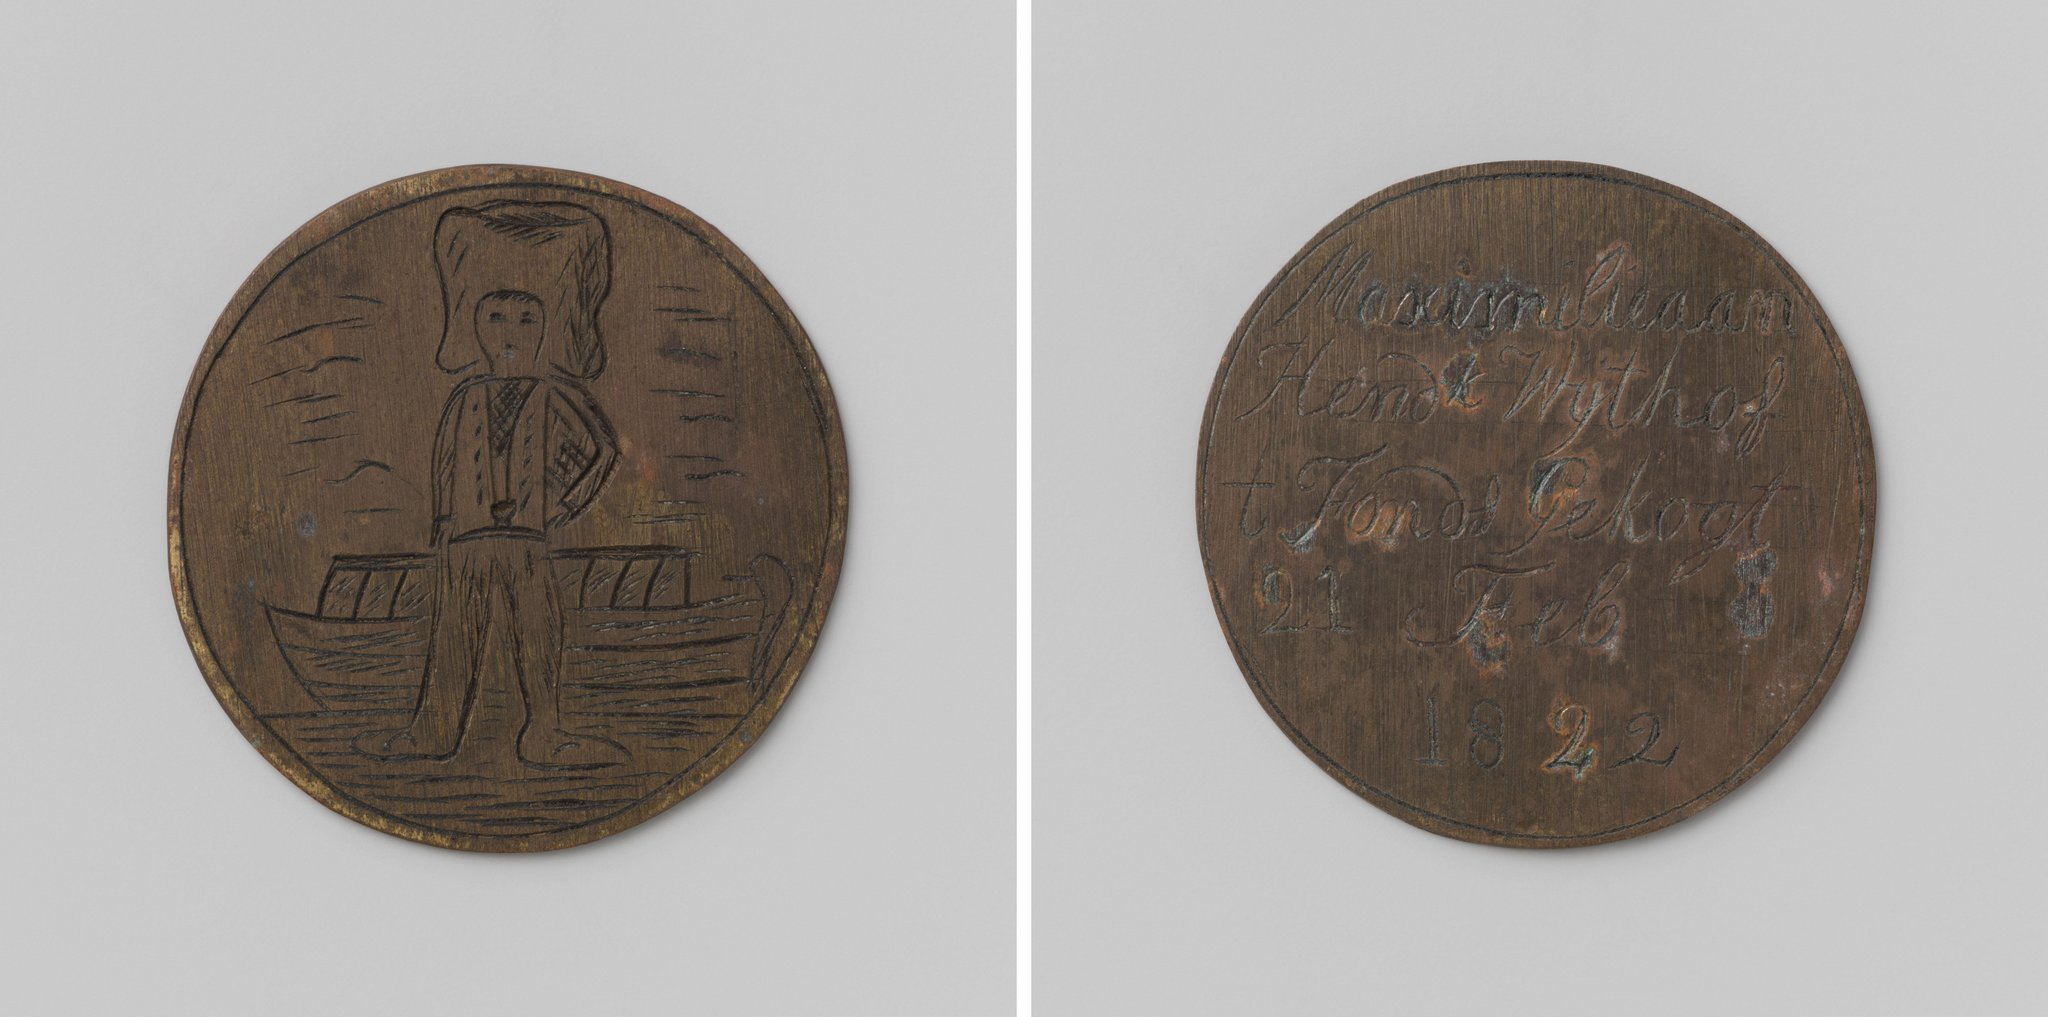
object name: medal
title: Korendragers- en -stortersgilde van Amsterdam, gildepenning van Maximiliaan Hendrik Wythof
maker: Anonymous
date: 1822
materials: copper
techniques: engraving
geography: amsterdam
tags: amsterdam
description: Koperen penning. Voorzijde: man met last op hoofd en face, staande voor lichterschuit. Keerzijde: opschrift